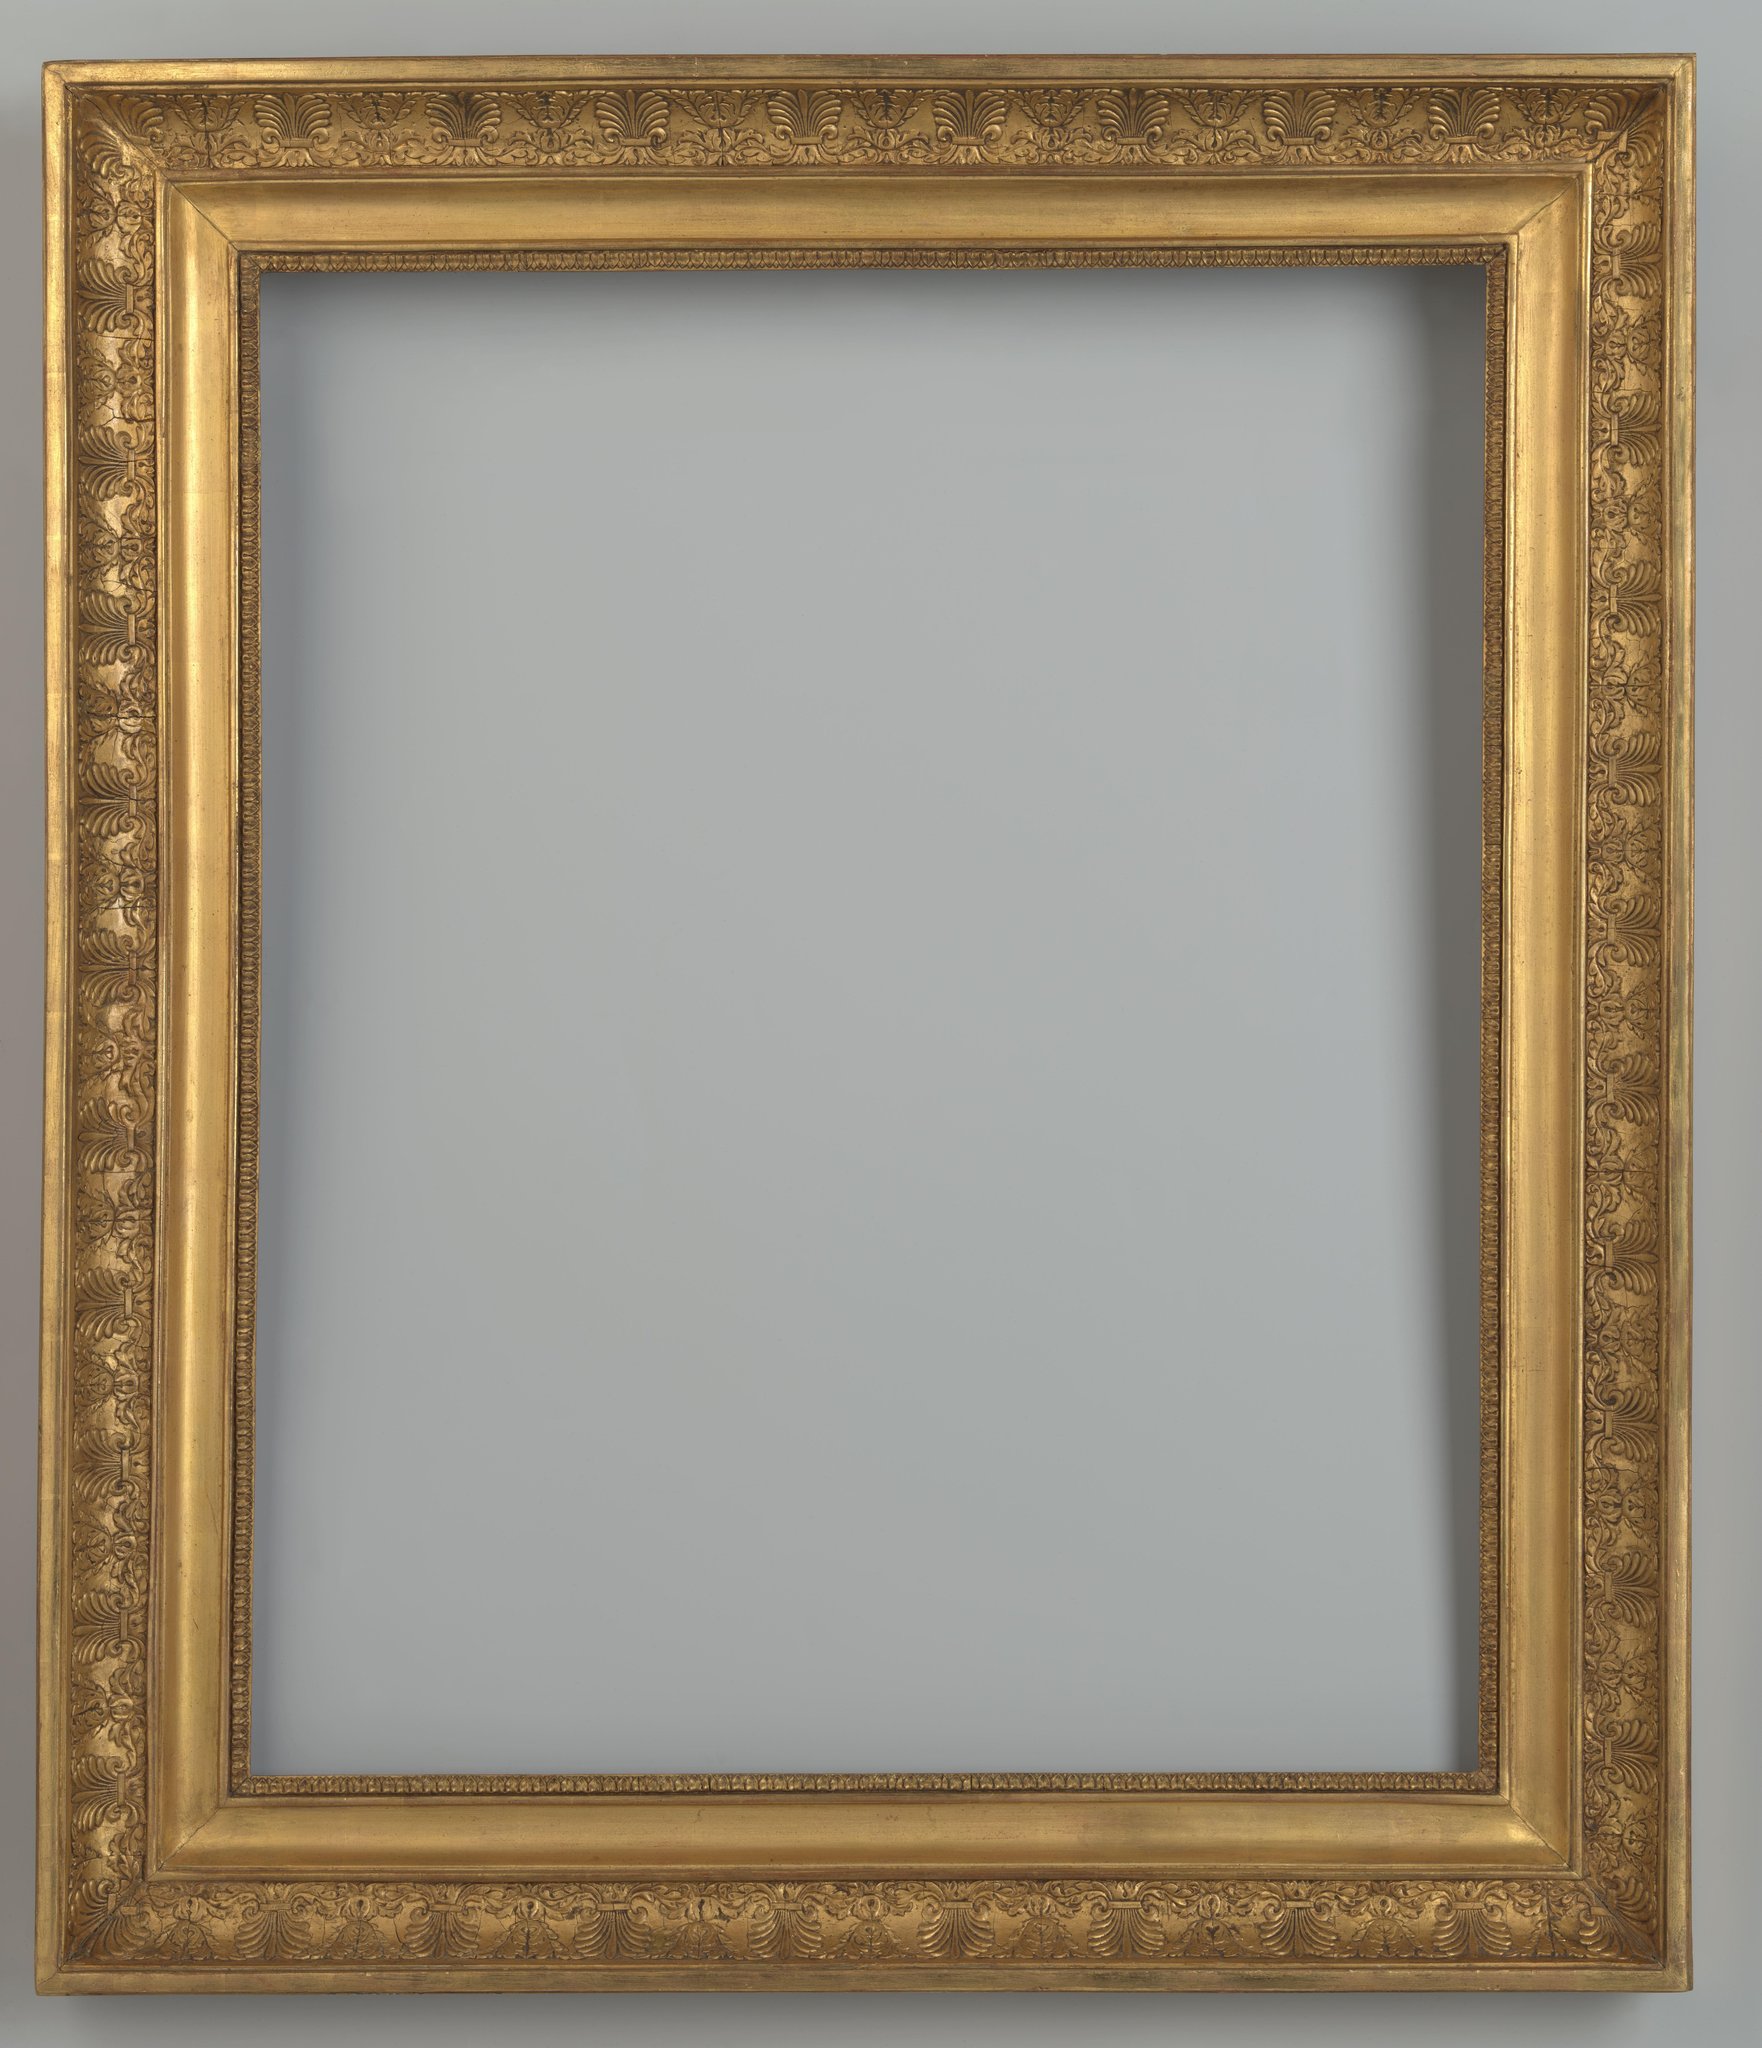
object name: frame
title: Vergulde empire lijst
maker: Anonymous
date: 1810-1820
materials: wood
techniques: gilding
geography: france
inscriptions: back: ‘Lallemand’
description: Vergulde lijst in empirestijl. Het profiel van de lijst is samengesteld uit achtereenvolgens een binnenrand met een ossentong-motief, een tussen twee platte treden liggende koof zonder decor, een koof met in pâte uitgevoerde alternerende, gestileerde palmetten en kamperfoelie-motieven, en een platte bekroning. De hoeken zijn in verstek met elkaar verbonden door middel van taps toelopende zwaluwstaartspieën.